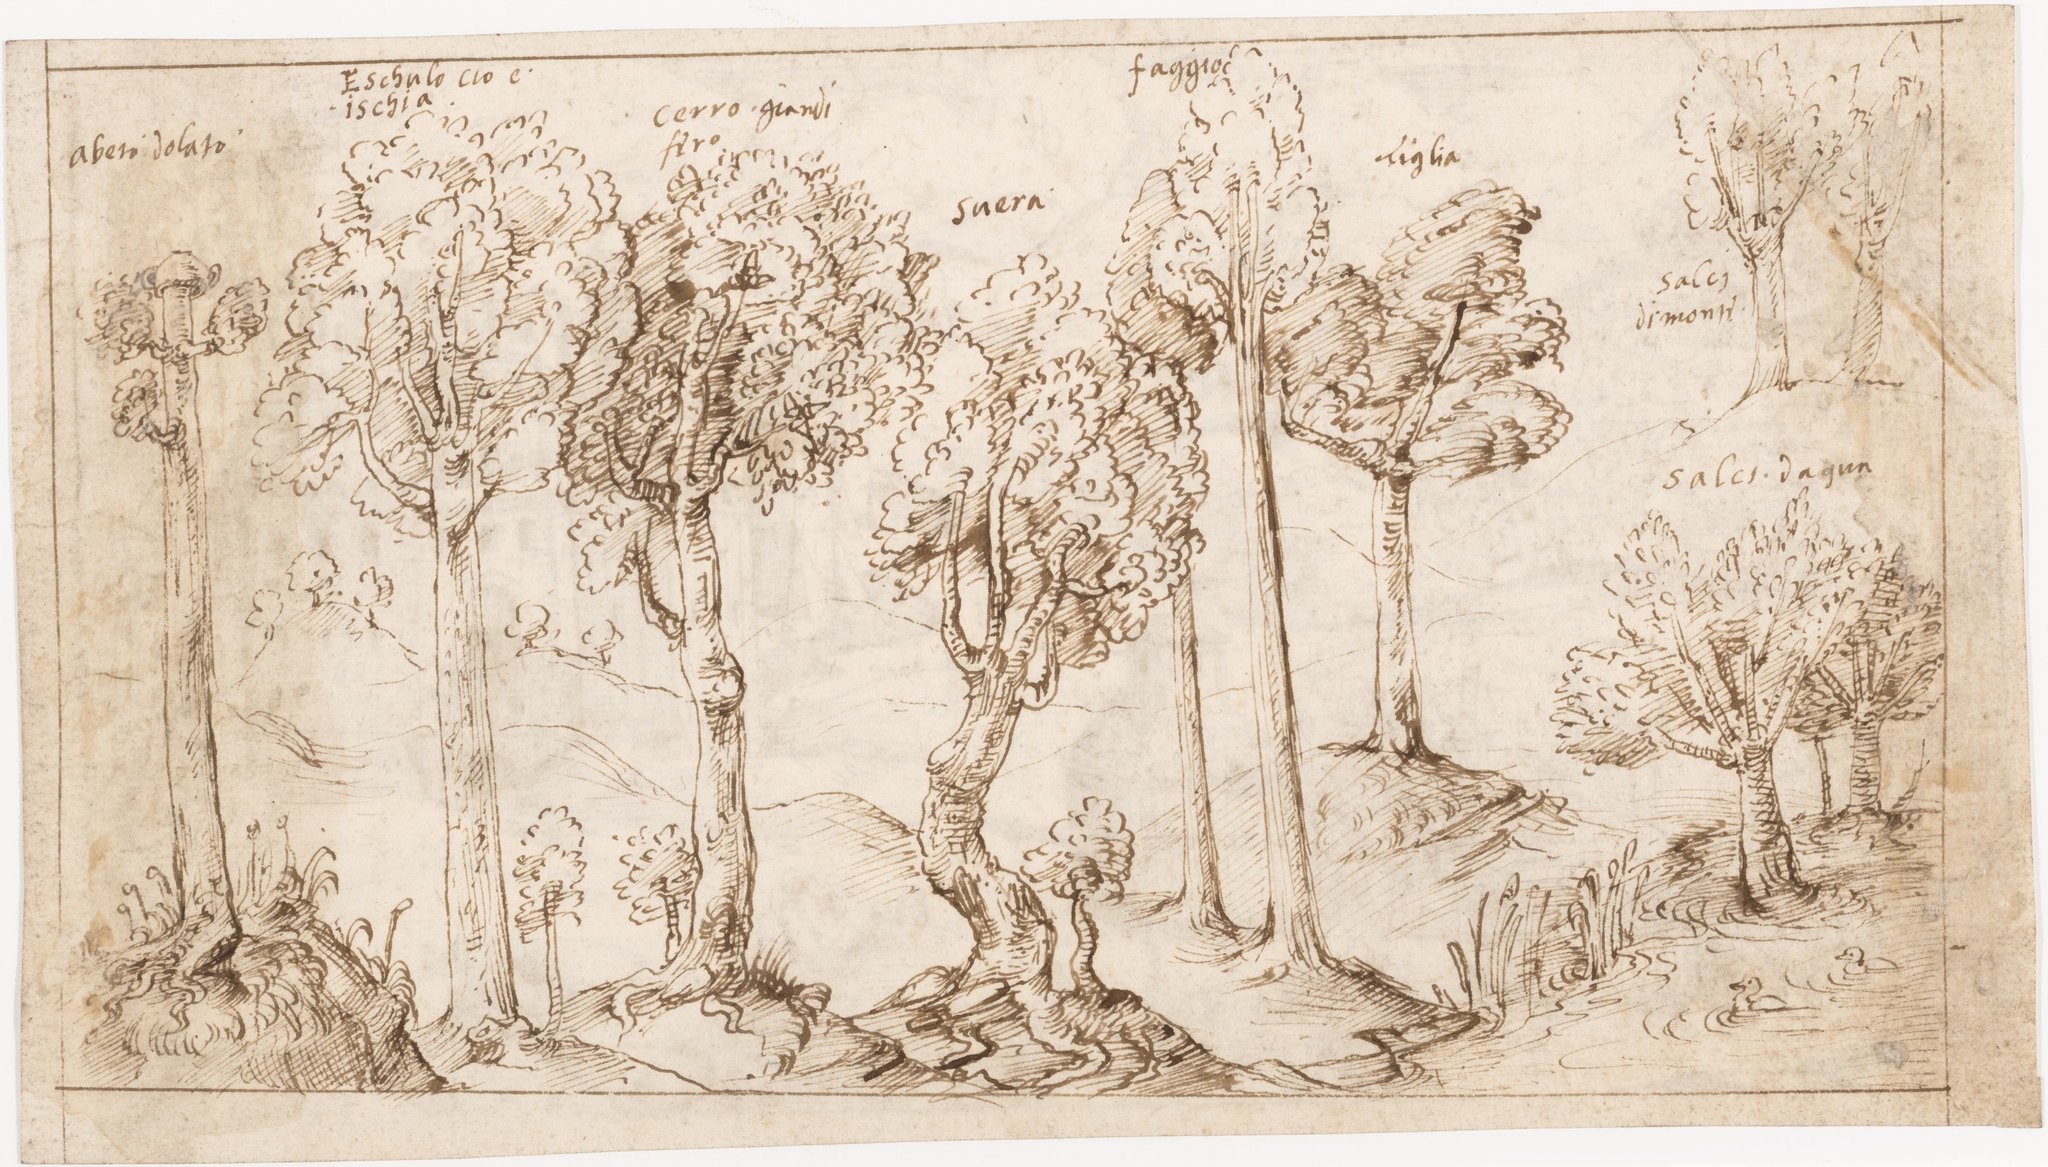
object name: drawing ornament architecture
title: Recto: On Timber, the Species of Trees (Vitruvius, Book 2, Chapter 9, no. 4); Verso: On Timber, the Battle of Larignium (Vitruvius, Book 2, Chapter 9, no. 15)..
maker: sangallo family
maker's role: artist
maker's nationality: italian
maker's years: 1530-1545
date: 1530-1545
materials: ink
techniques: pen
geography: france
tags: trees